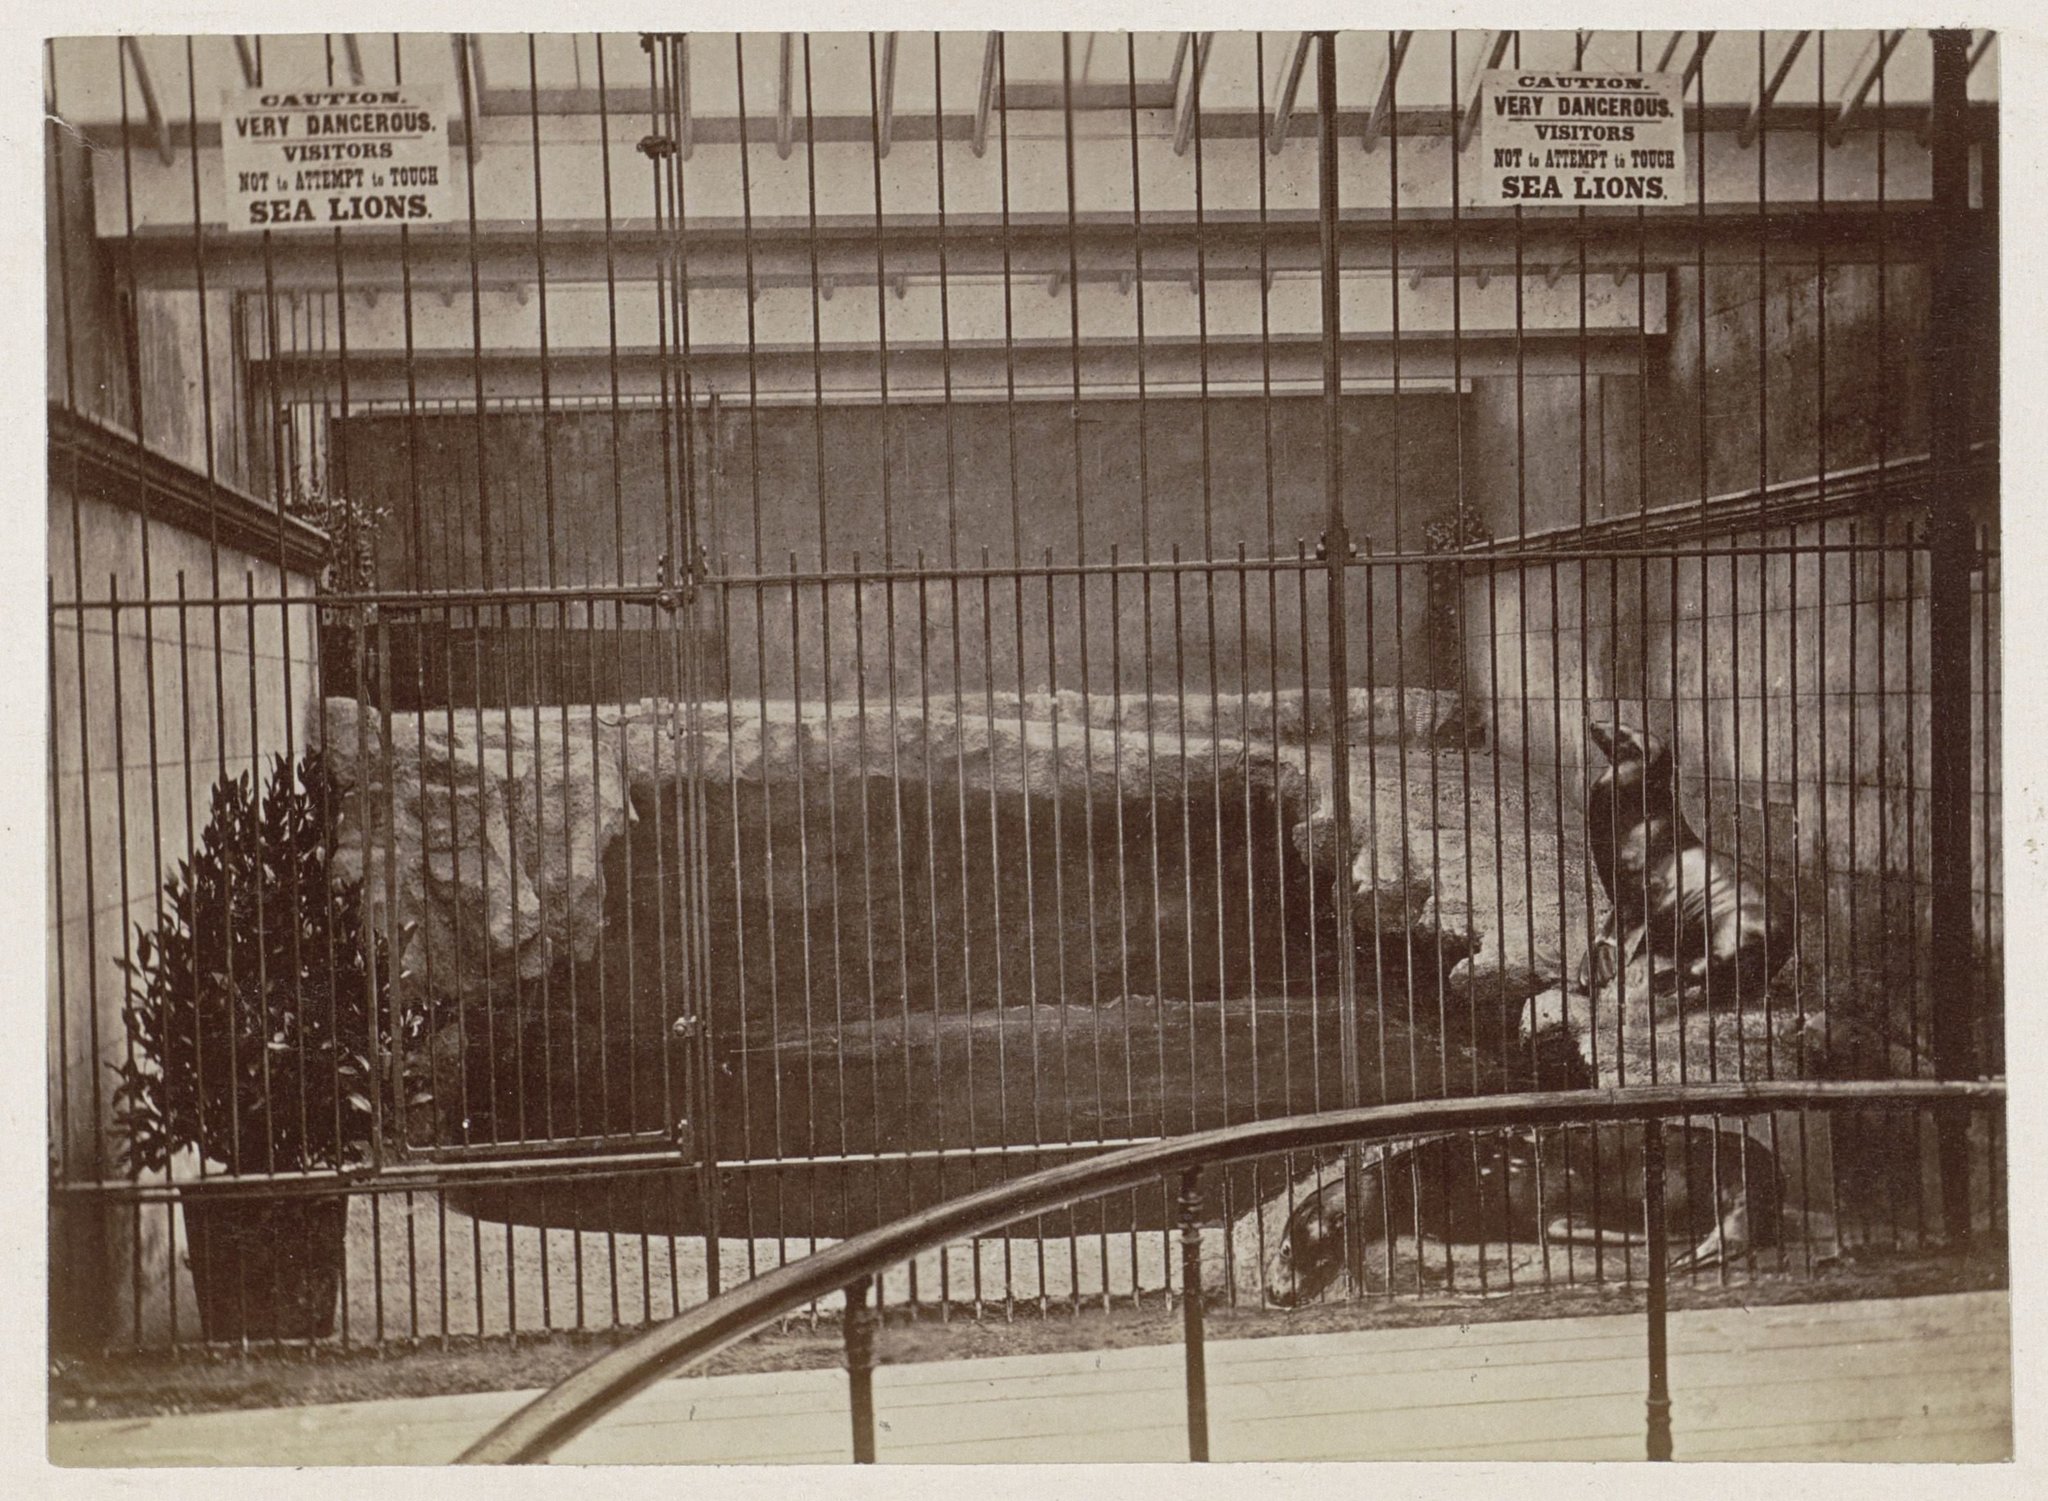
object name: photograph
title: Traliekooi met zeeleeuwen en waarschuwingsborden in het aquarium van Brighton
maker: Anonymous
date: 1878-1890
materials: photographic support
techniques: albumen print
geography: brighton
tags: aquarium, swimming mammals: sea lion, zoo (as place of recreation)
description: Onderdeel van Reisalbum Europese steden, vermoedelijk Zweeds.